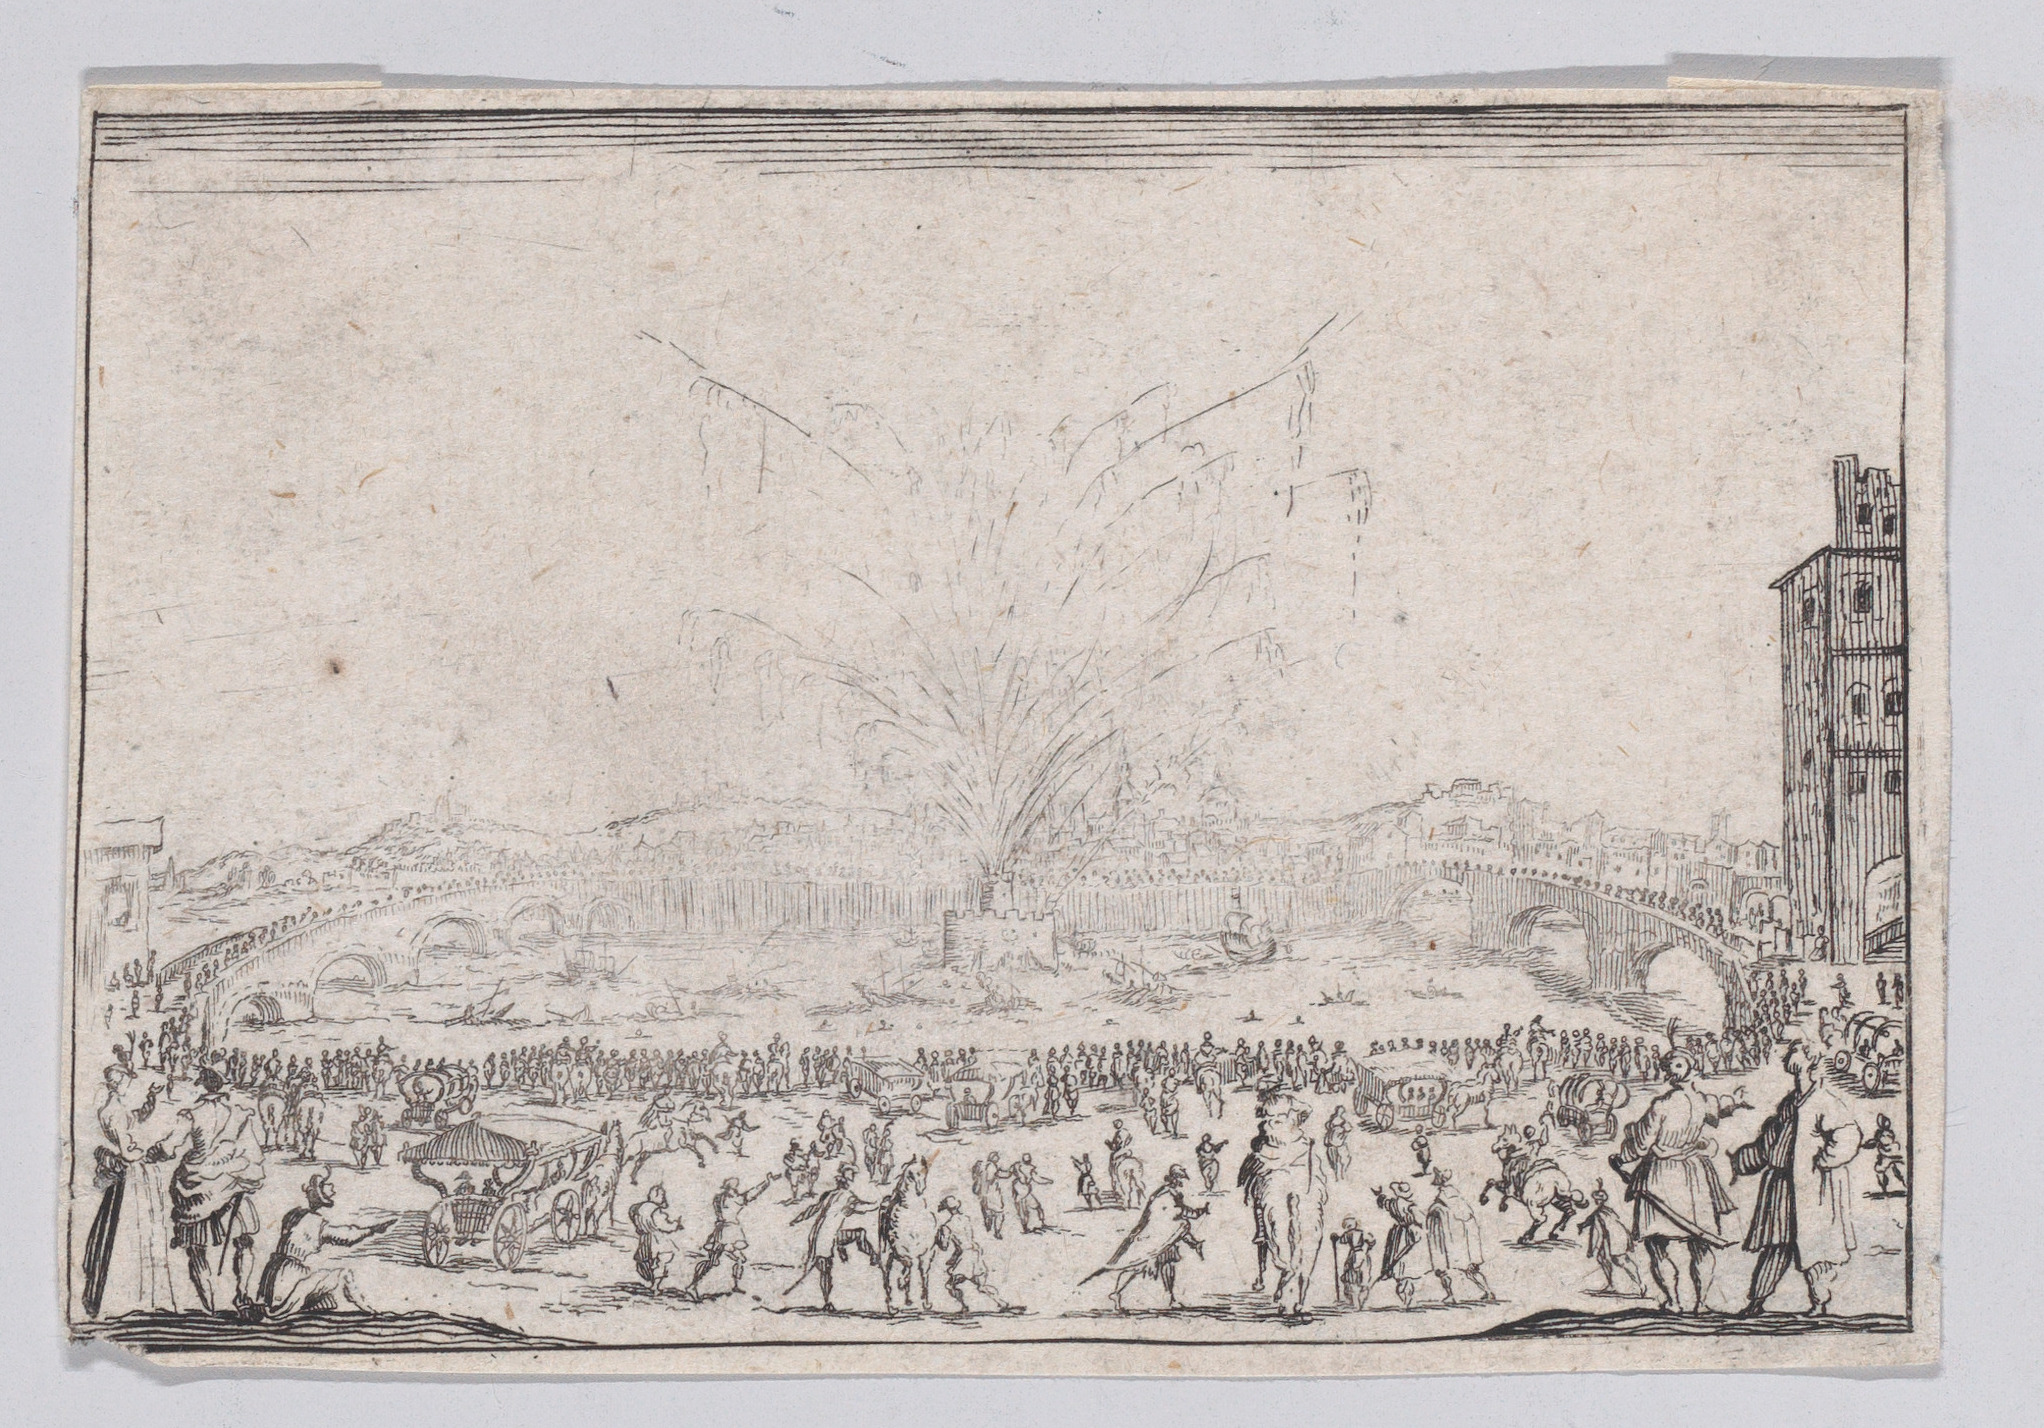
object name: print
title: Reverse Copy of Le Feu d'Artifice sur l'Arno (Fireworks on the Arno), from "Les Caprices"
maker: Anonymous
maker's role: artist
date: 1601-1700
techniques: etching